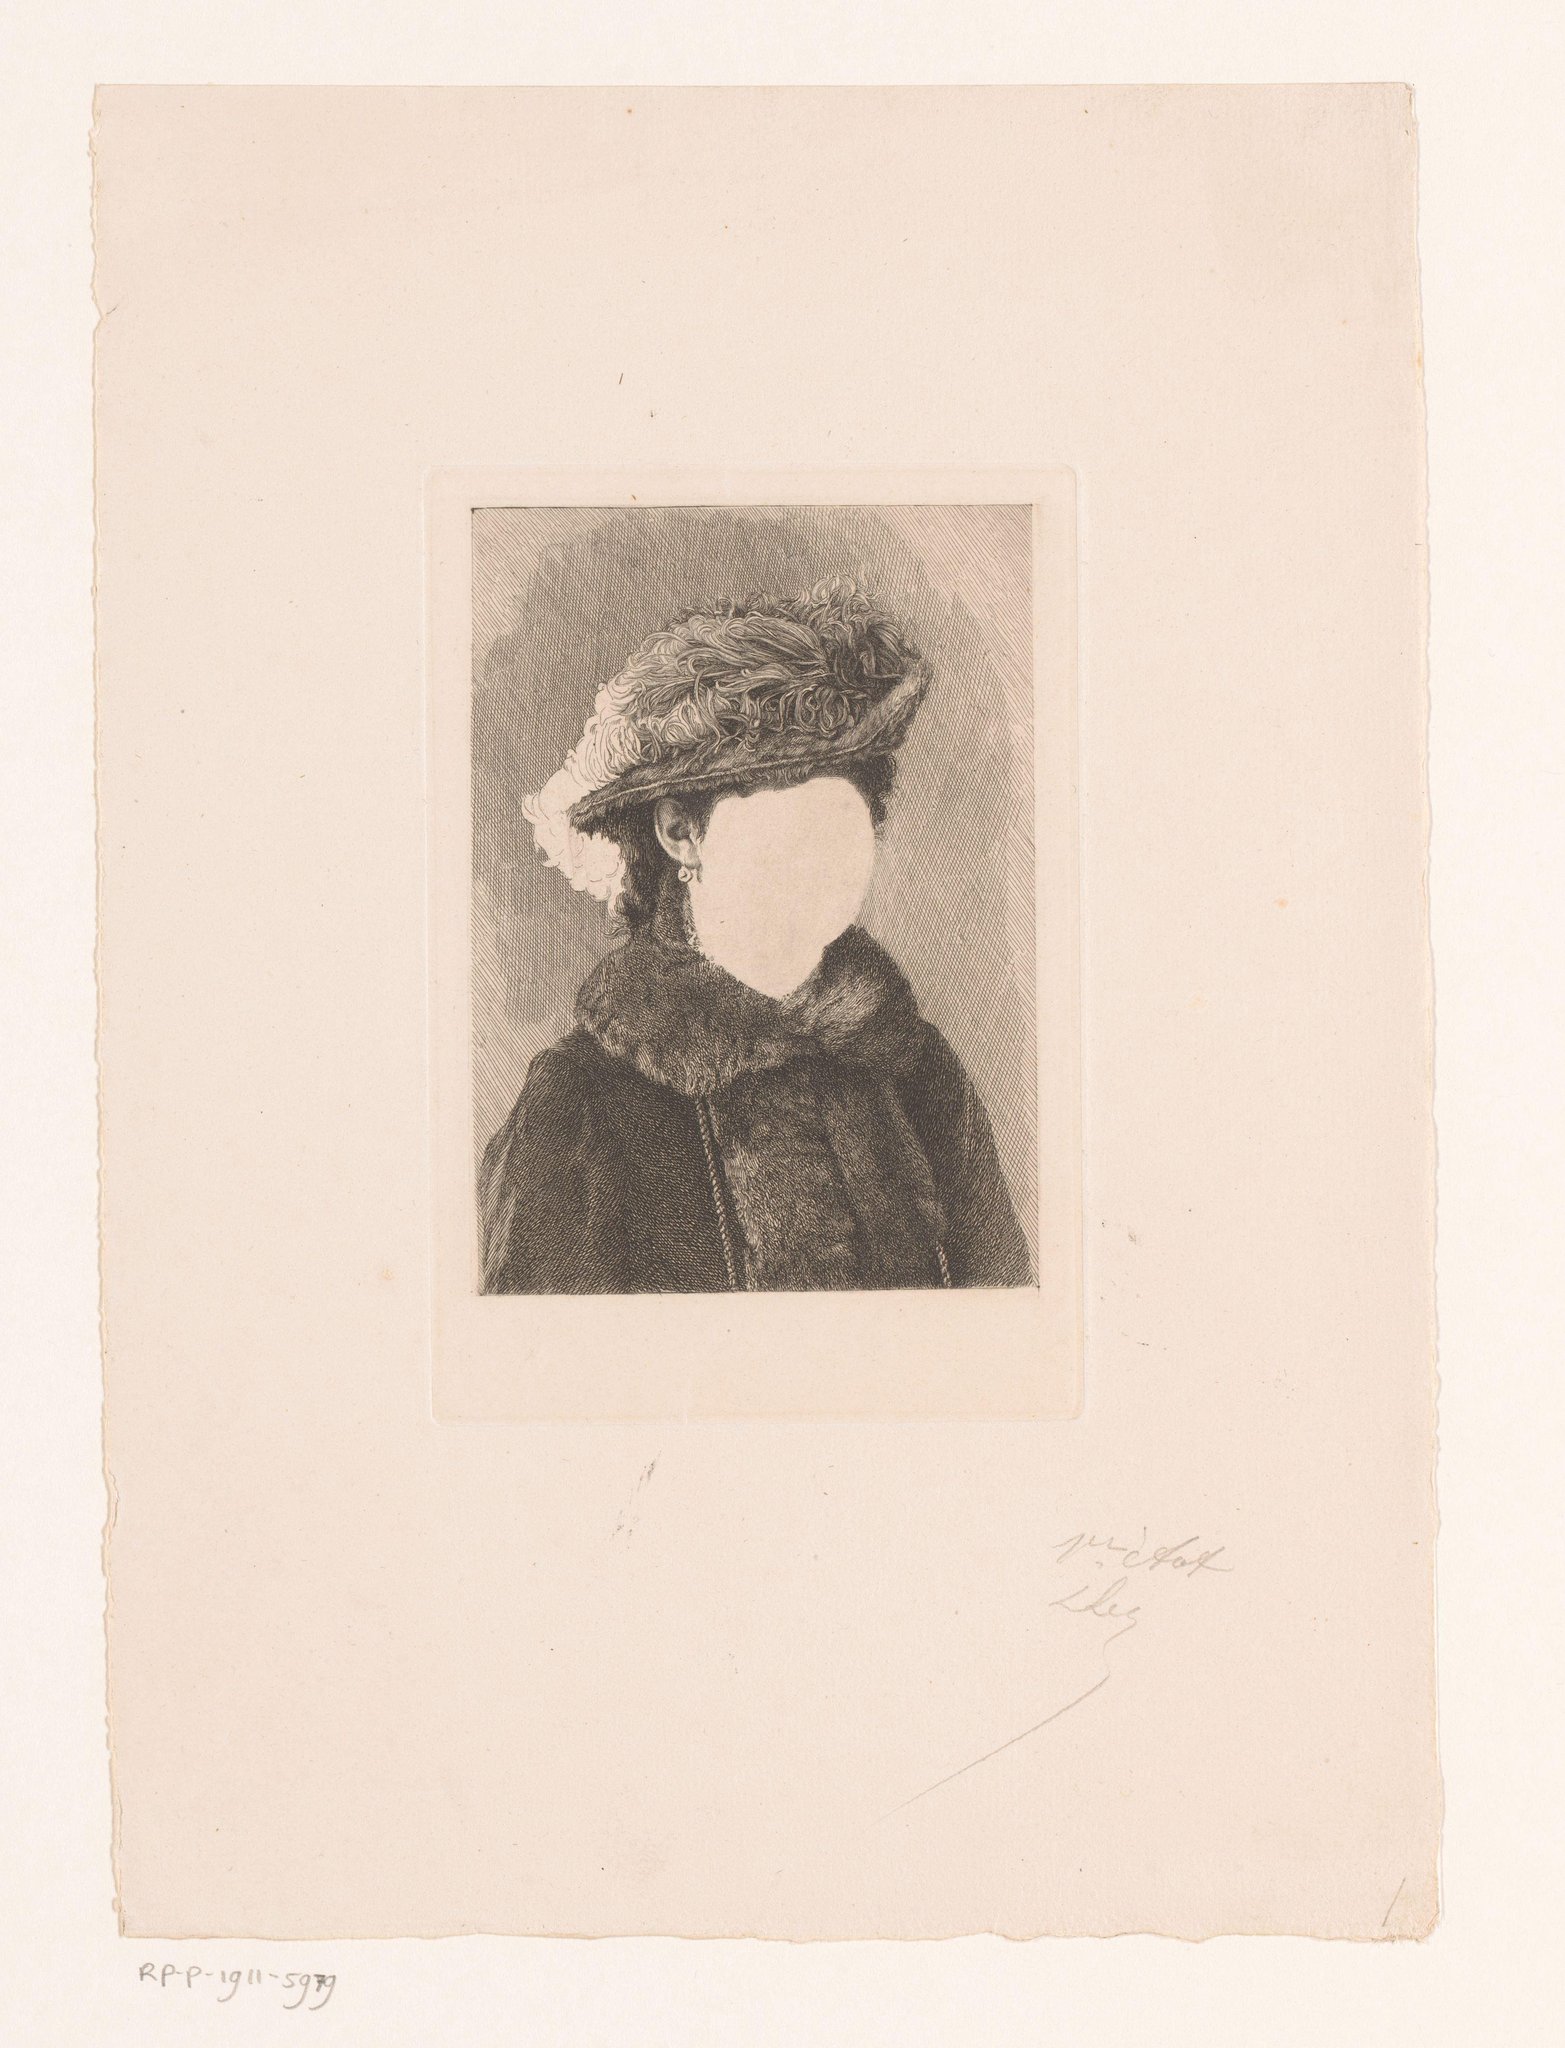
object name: print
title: Portret van een onbekende vrouw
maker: louis le nain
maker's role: print maker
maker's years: 1851-1939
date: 1861-1911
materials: paper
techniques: etching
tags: adult woman, head-gear, historical persons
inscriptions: inscription: ‘[...] état LLe’, collector's mark: Lugt 2228